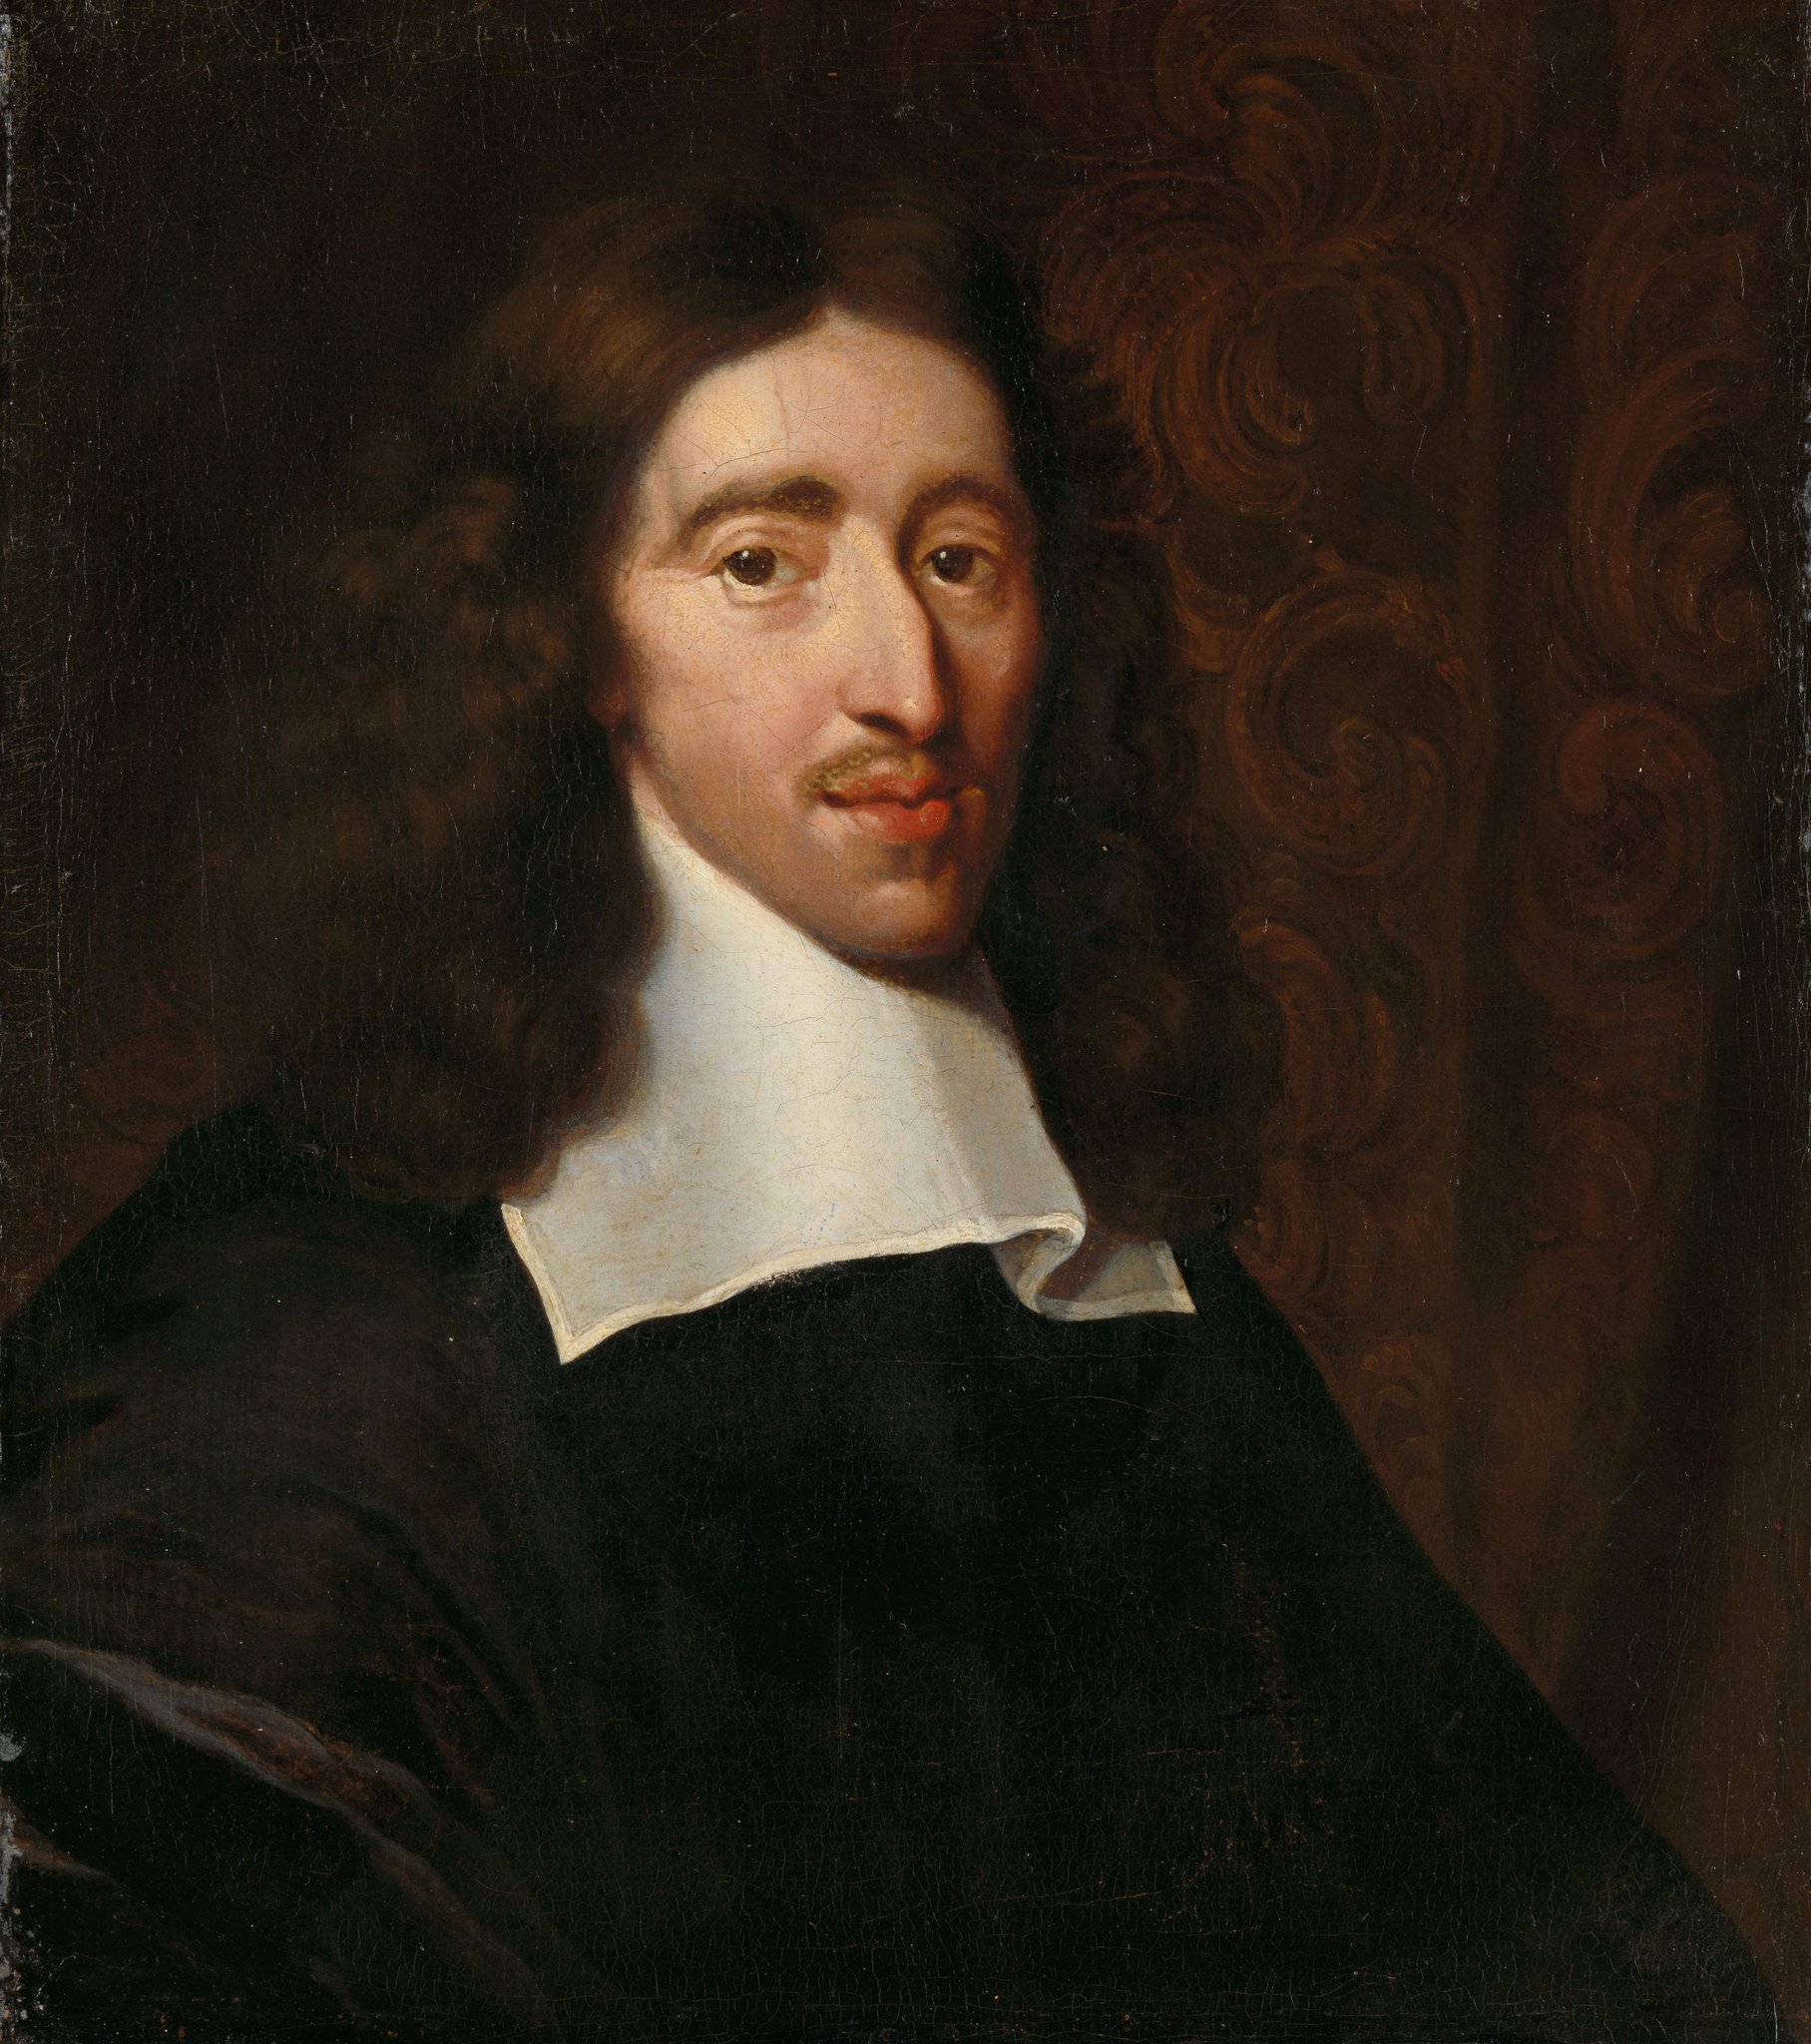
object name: painting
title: Portrait of Johan de Witt (1625-72), Grand pensionary of Holland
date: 1660-1700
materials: canvas, oil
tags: the hague, politician, johan de witt, historical persons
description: Portret van Johan de Witt, raadpensionaris van Holland. Buste naar rechts.